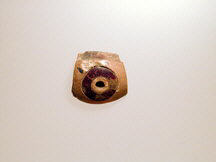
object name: fibula, fragment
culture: etruscan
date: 700-501 BCE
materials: amber